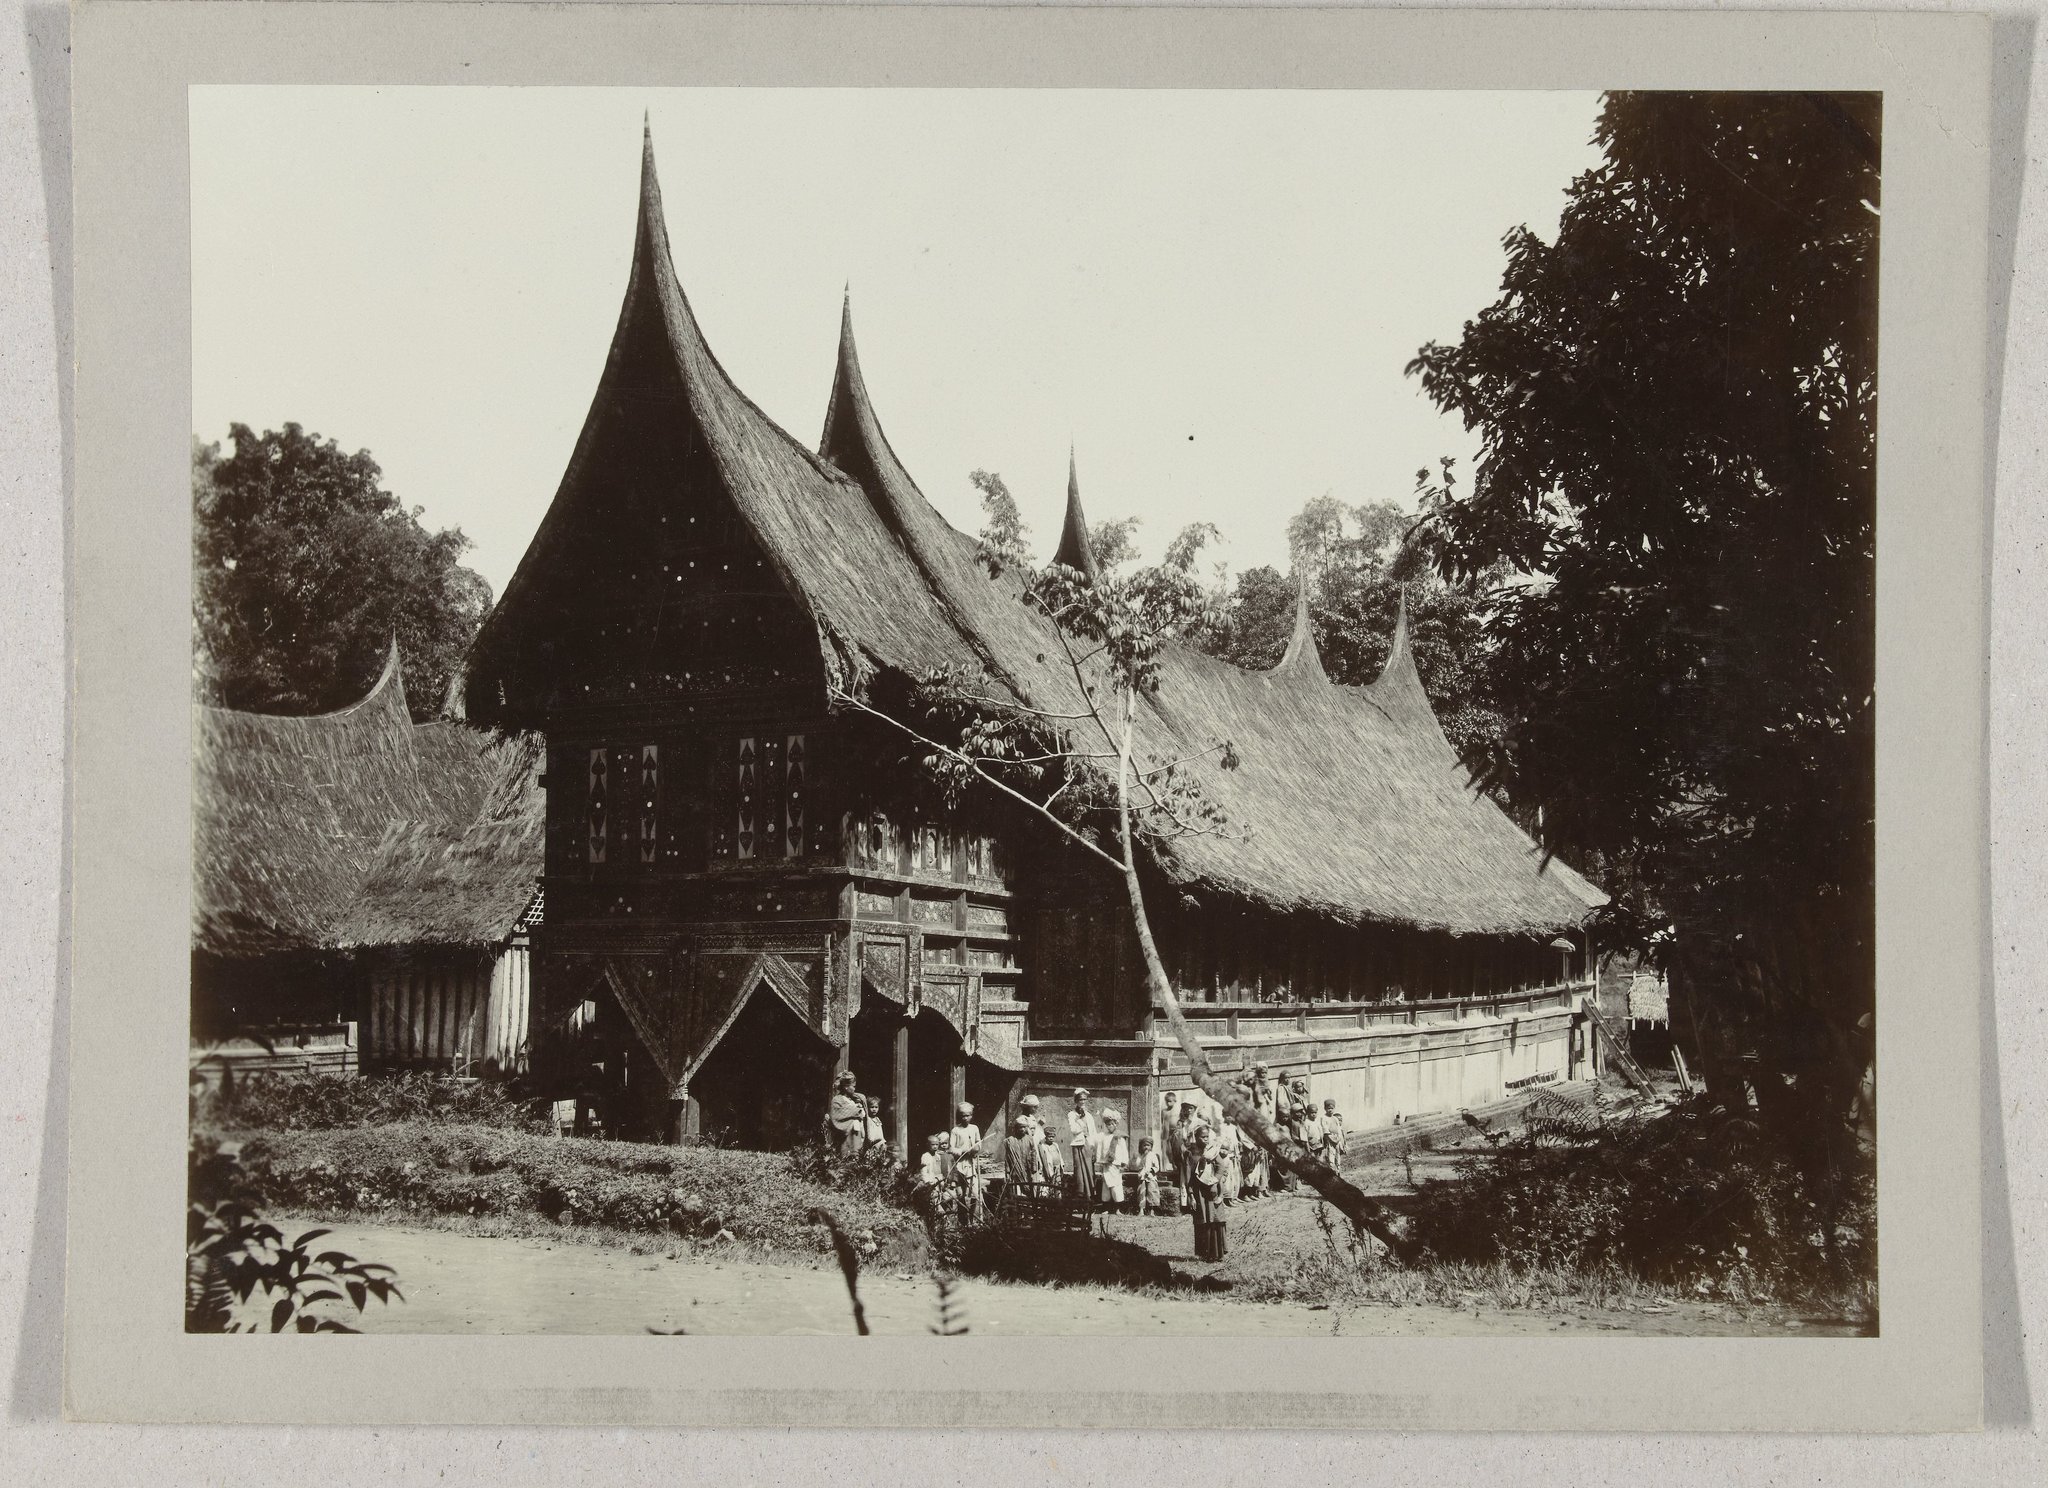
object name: photograph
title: Minangkabau huis op Sumatra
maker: Anonymous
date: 1895-1915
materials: cardboard, paper, photographic support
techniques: gelatin silver print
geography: sumatra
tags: indonesia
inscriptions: annotation: ‘4. Sumatra-huis’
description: Minangkabau huis, Sumatra, Nederlands-Indië. Vrouwen en kinderen voor het huis.